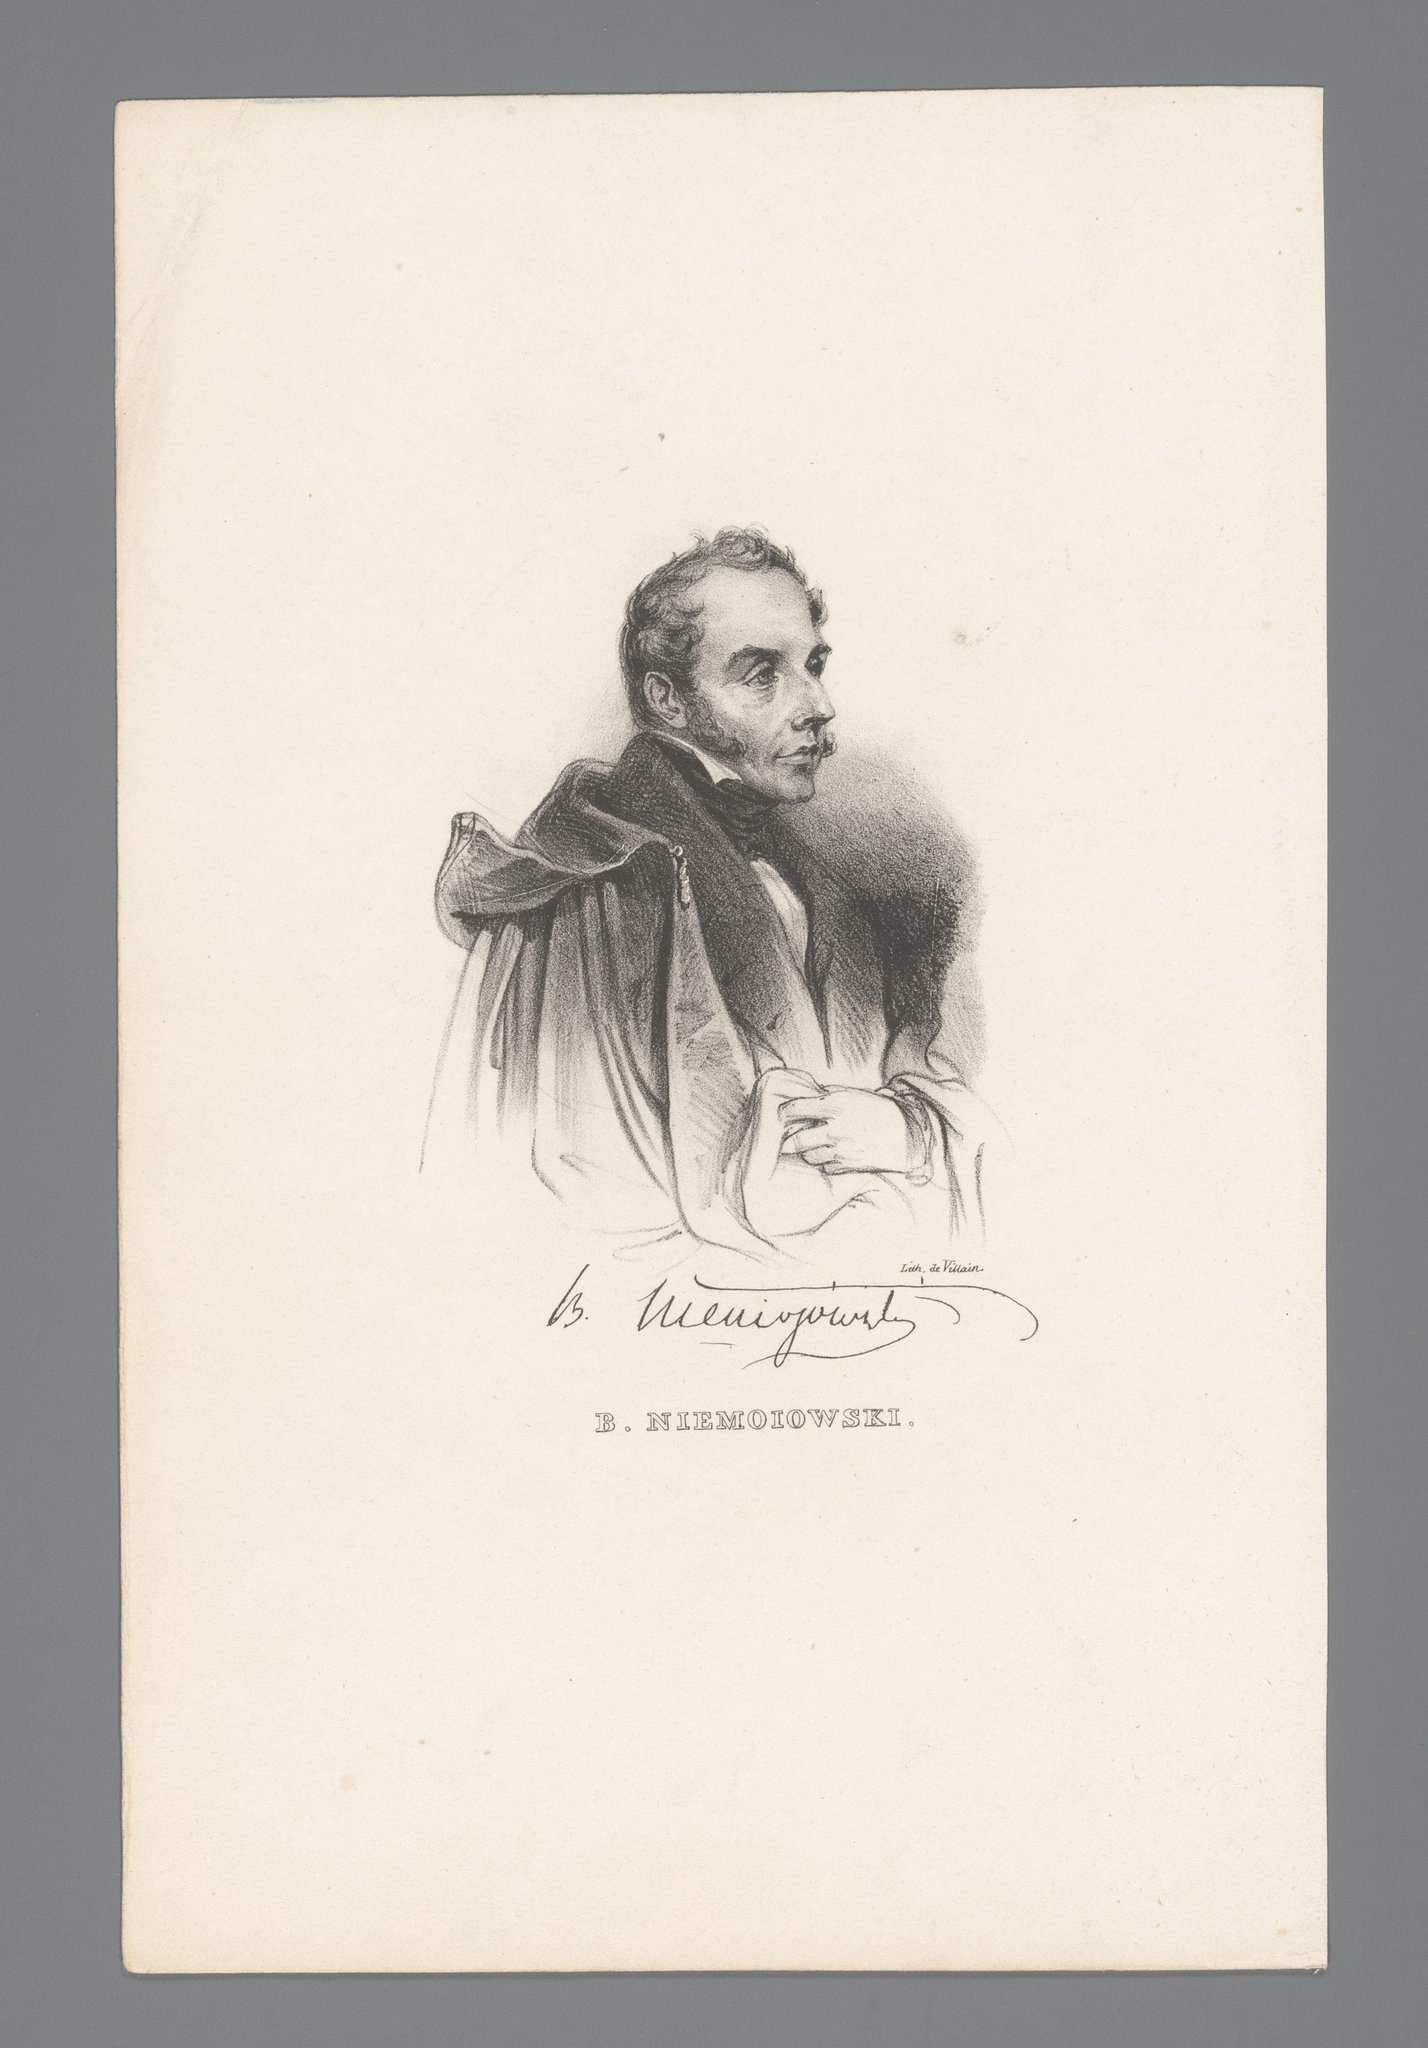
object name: book illustration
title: B. Niemoiowski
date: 1832-1839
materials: paper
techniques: lithograph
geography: paris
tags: paris, politician, historical persons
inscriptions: collector's mark: Lugt 2228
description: Prent uit: Straszewicz., Joseph. Les polonais et les polonaises de la révolution du 29 novembre 1830, ou Portraits des personnes qui ont figuré dans la dernière guerre de l'indépendance polonaise, avec les fac-simile de leur signature, lithographiés sur dessins originaux, par les artistes les plus distingués: MM. Grévedon, Maurin, Vigneron, Belliard, Devéria, Bazin, Desmadryl, Lecler, Desmaisons, Rutowski, officier polonais, etc,. etc., accompagnés d'une biographie pour chaque portrait. Parijs: Catherine-Anaïs Pinard, 1832. Of uit: Straszewicz., Joseph. Les polonais et les polonaises de la révolution du 29 novembre 1830. Biographie des personnes qui ont figuré dans la dernière guerre de l'indépendance polonaise, avec les fac-simile de leur signature, ornée de 30 portraits lithographiés sur dessins originaux, par les artistes les plus distingués: MM. Grévedon, Maurin, Vigneron, Belliard, Devéria, Bazin, Desmadryl, Lecler, etc., etc.. Parijs: s.n., 1839.